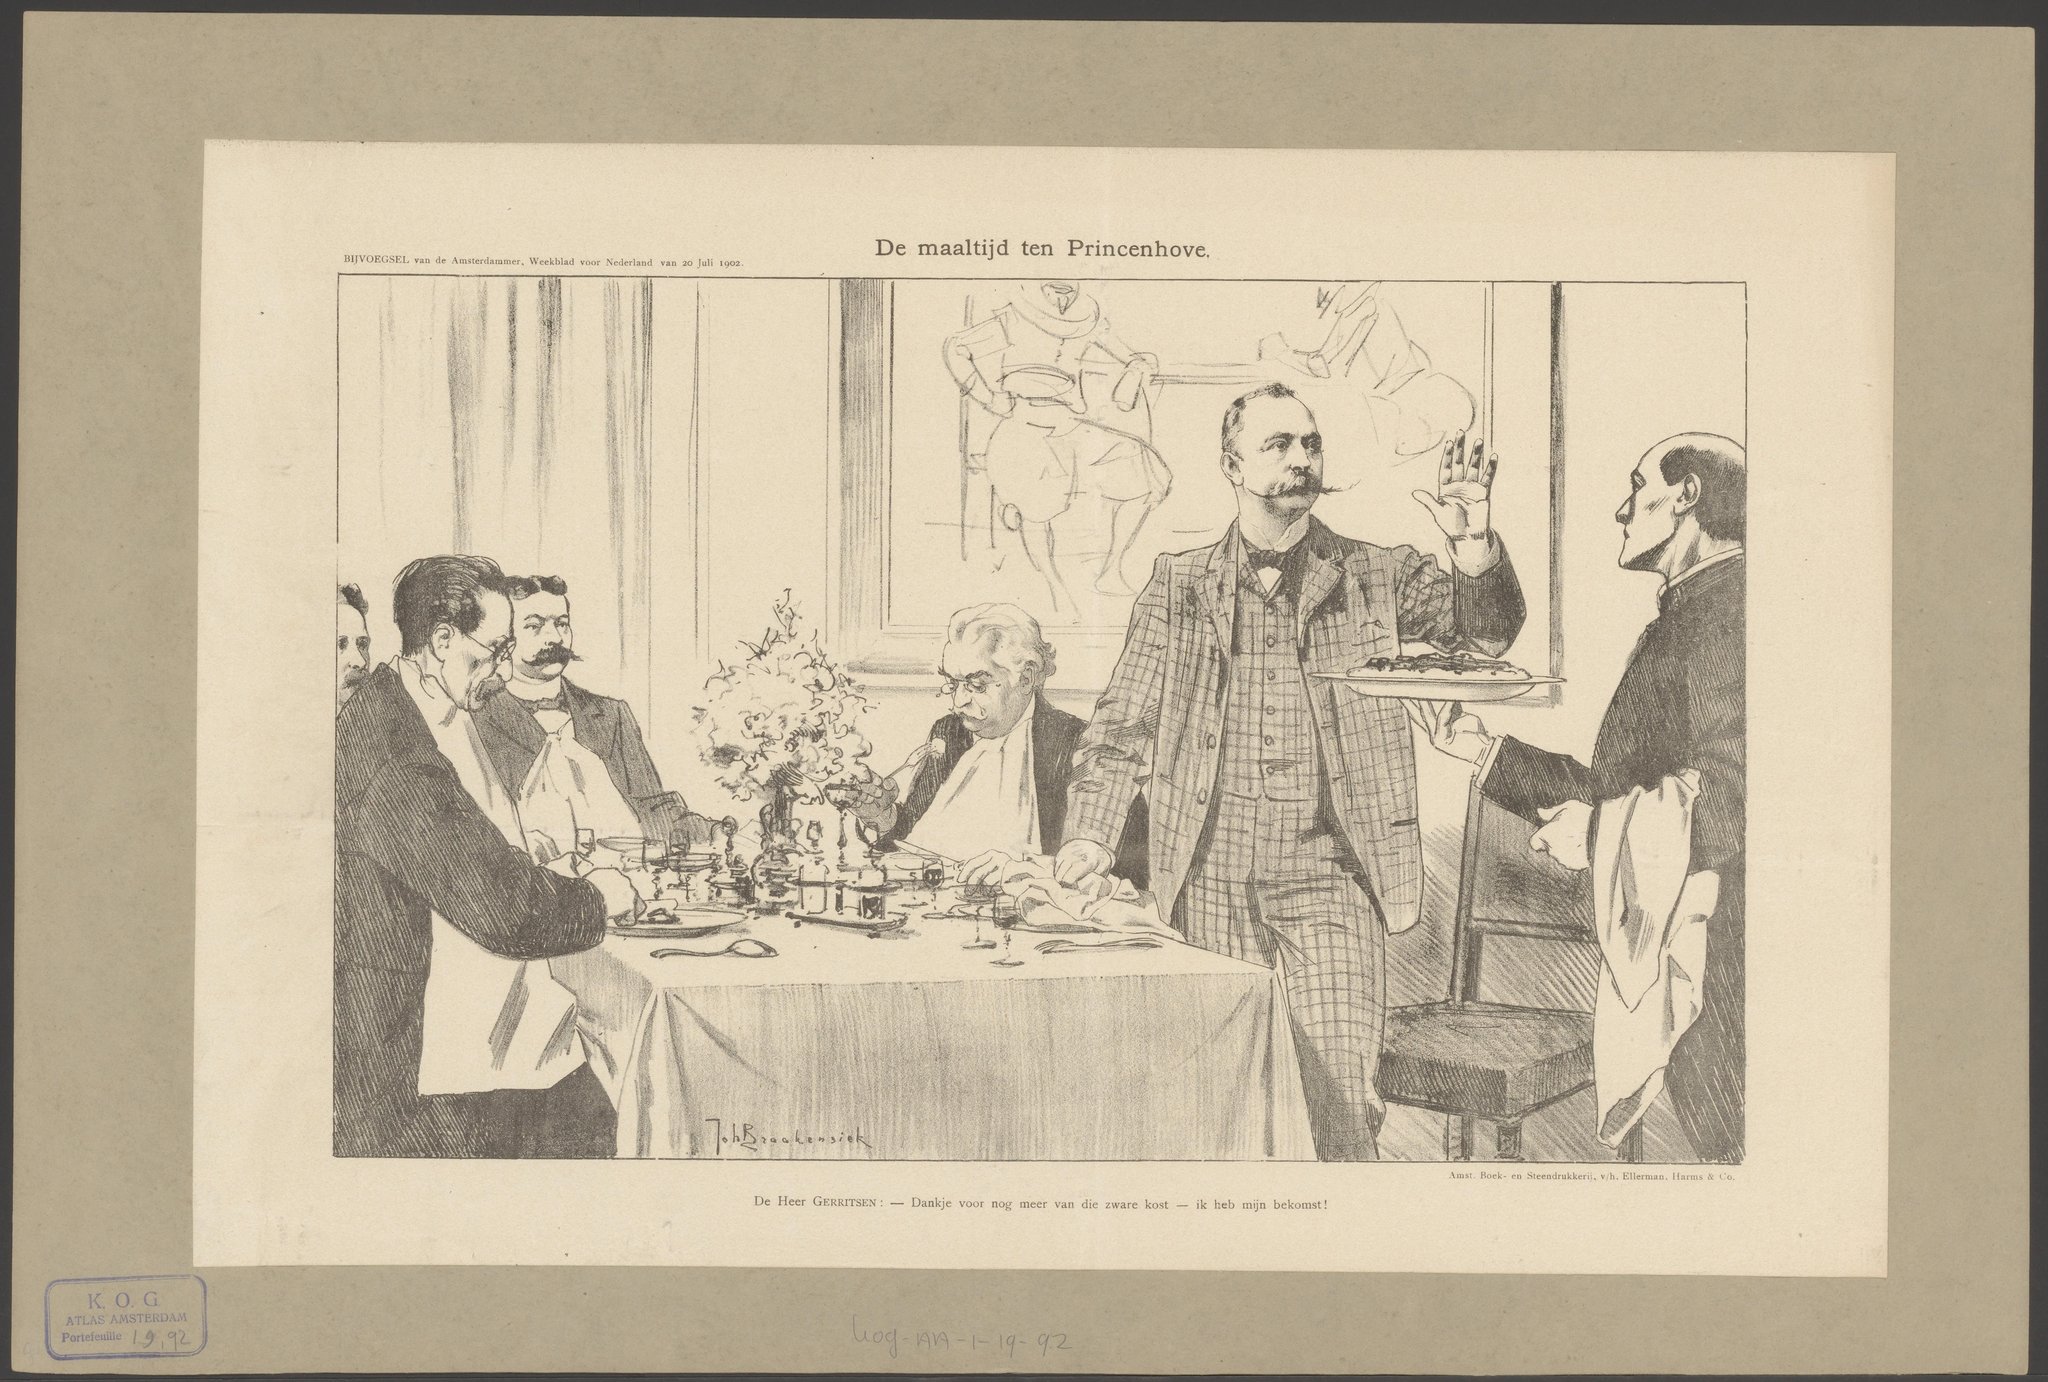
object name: cartoon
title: De maaltijd ten Princenhove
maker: johan braakensiek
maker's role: draughtsman, print maker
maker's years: 1858-1940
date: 1902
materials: paper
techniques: letterpress printing, lithograph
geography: amsterdam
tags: political caricatures and satires, amsterdam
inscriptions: collector's mark: ‘19,92’ Lugt 1641b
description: Onderwerpsrubriek binnen de Atlas Amsterdam: Herinneringen aan regeringsleden en hunne huisgezinnen [na 1800].